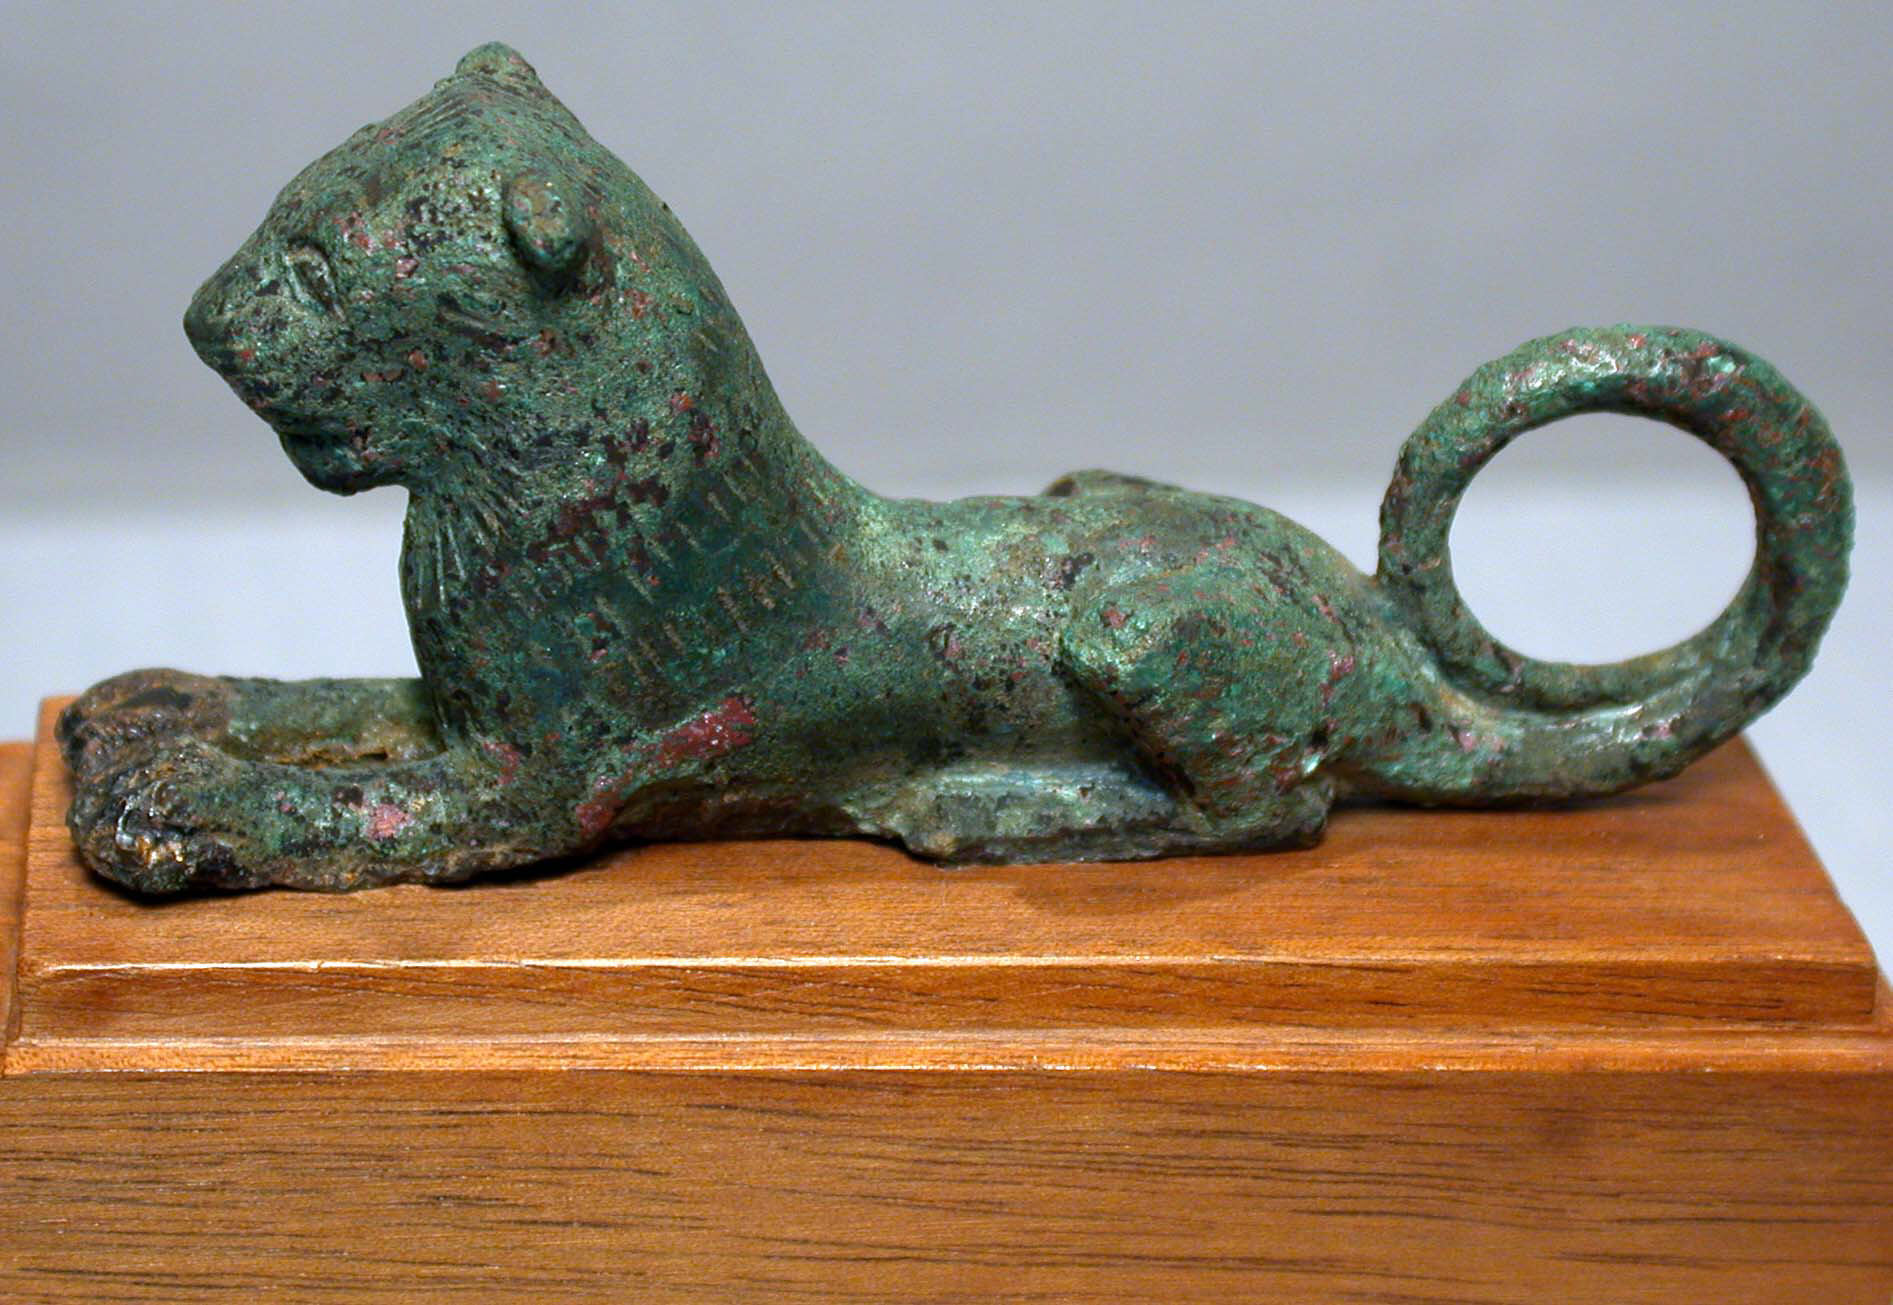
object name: figure of a recumbent lion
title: Bronze figure of a recumbent lion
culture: etruscan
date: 550-500 BCE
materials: bronze